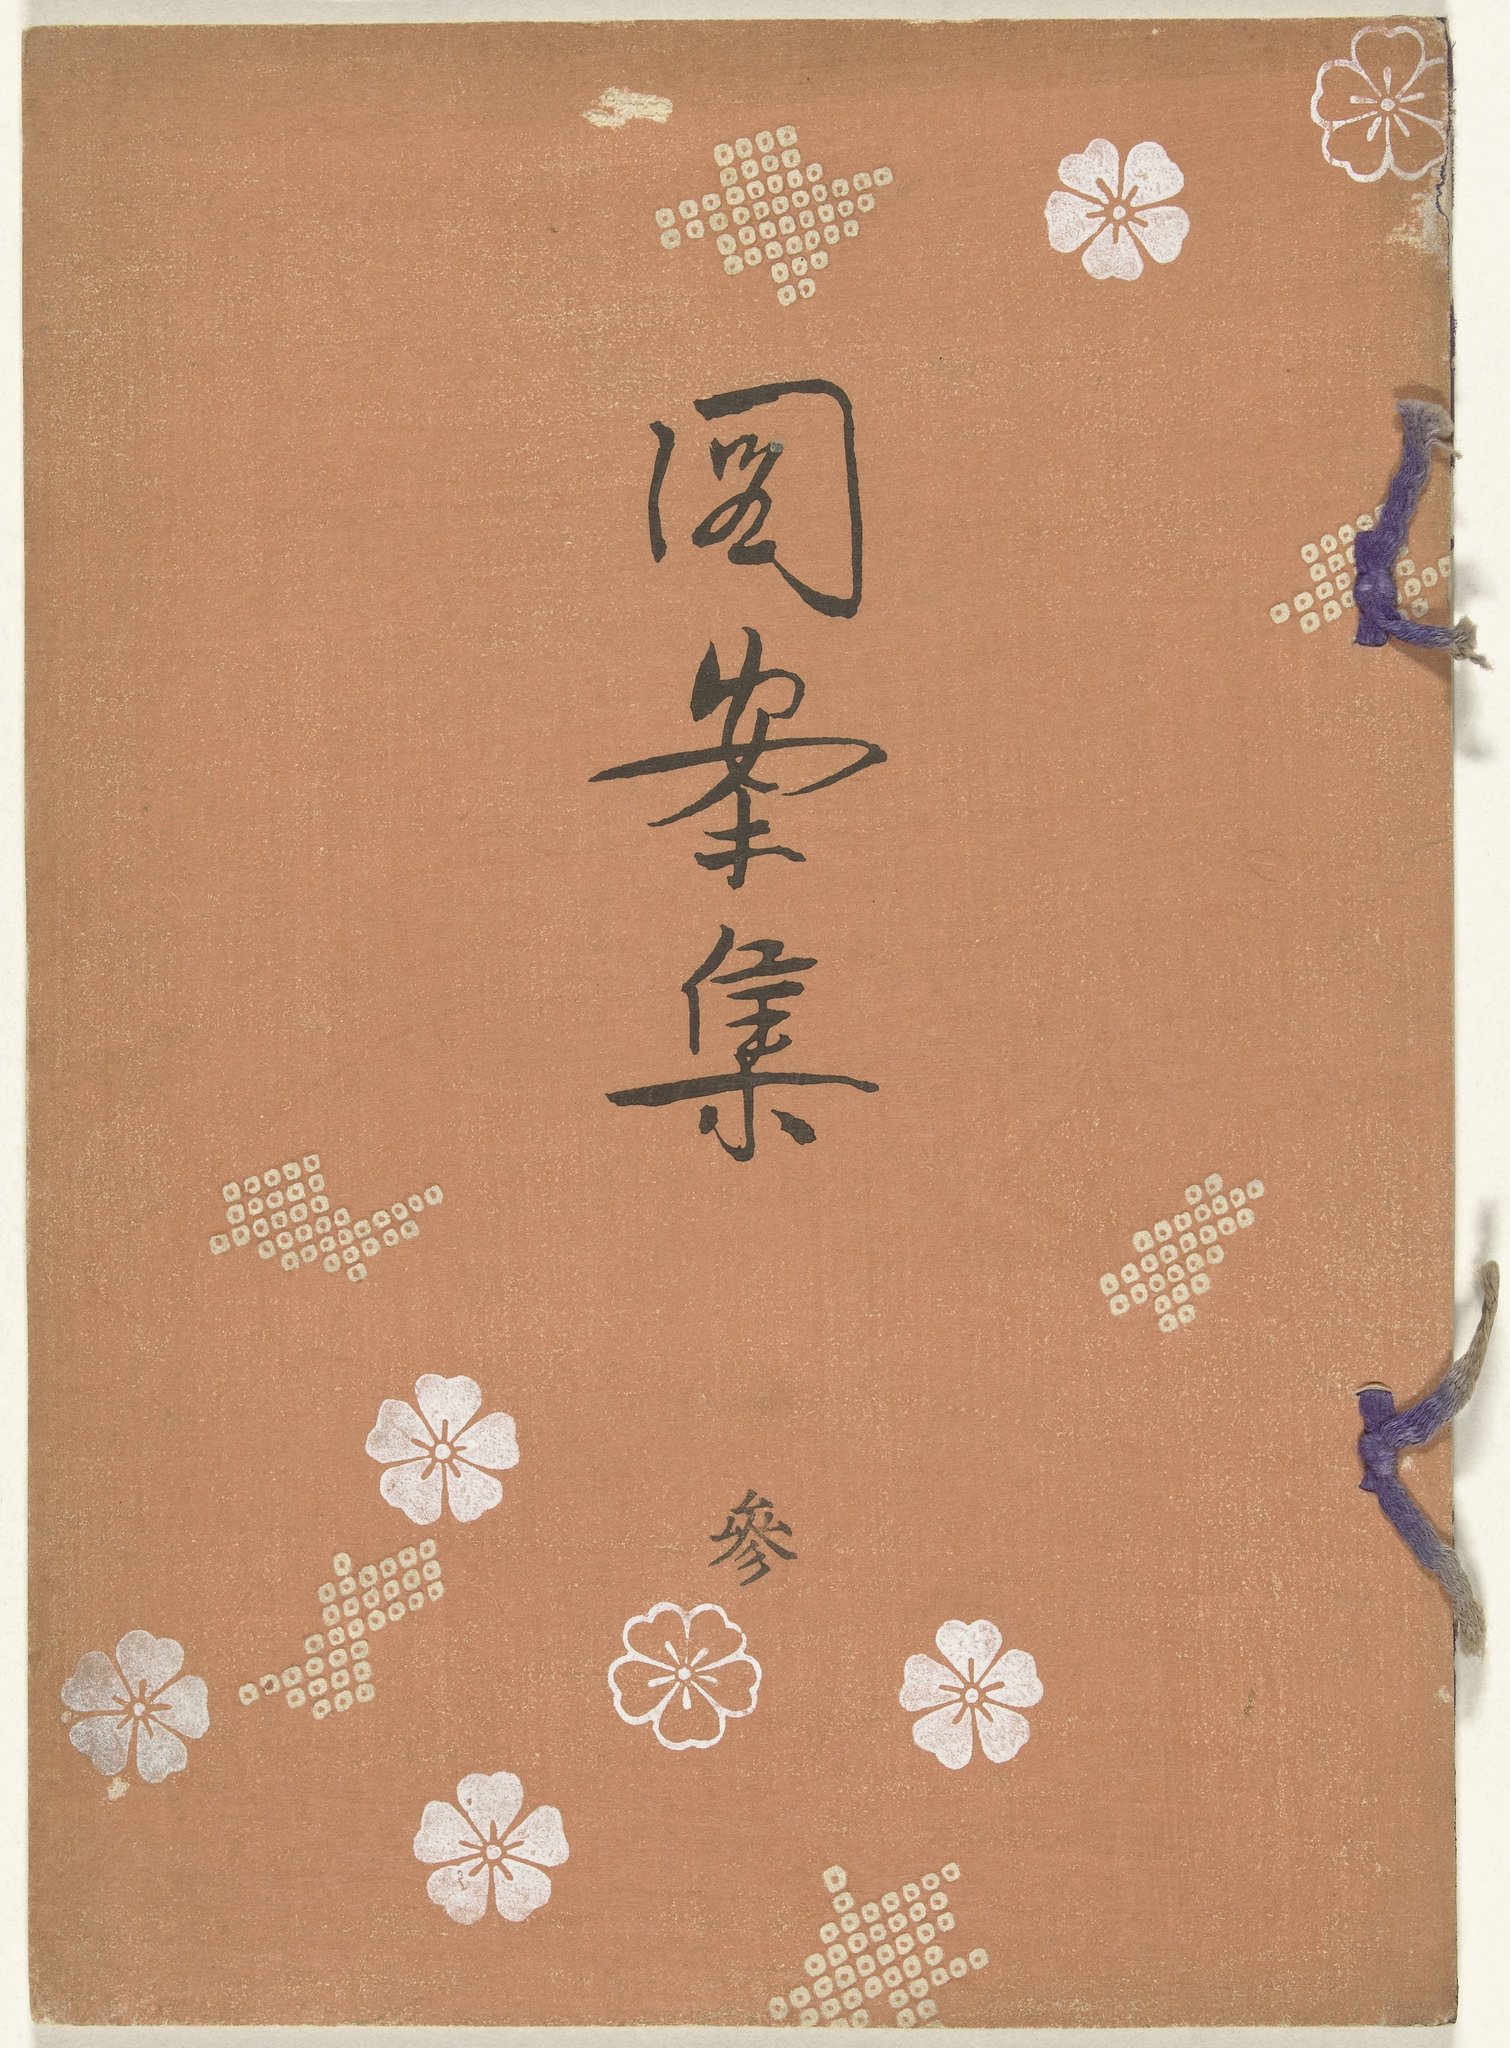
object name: book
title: Verzameling ontwerpen - drie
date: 1900-1910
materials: gold powder, paper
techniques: woodcut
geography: kyoto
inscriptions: date